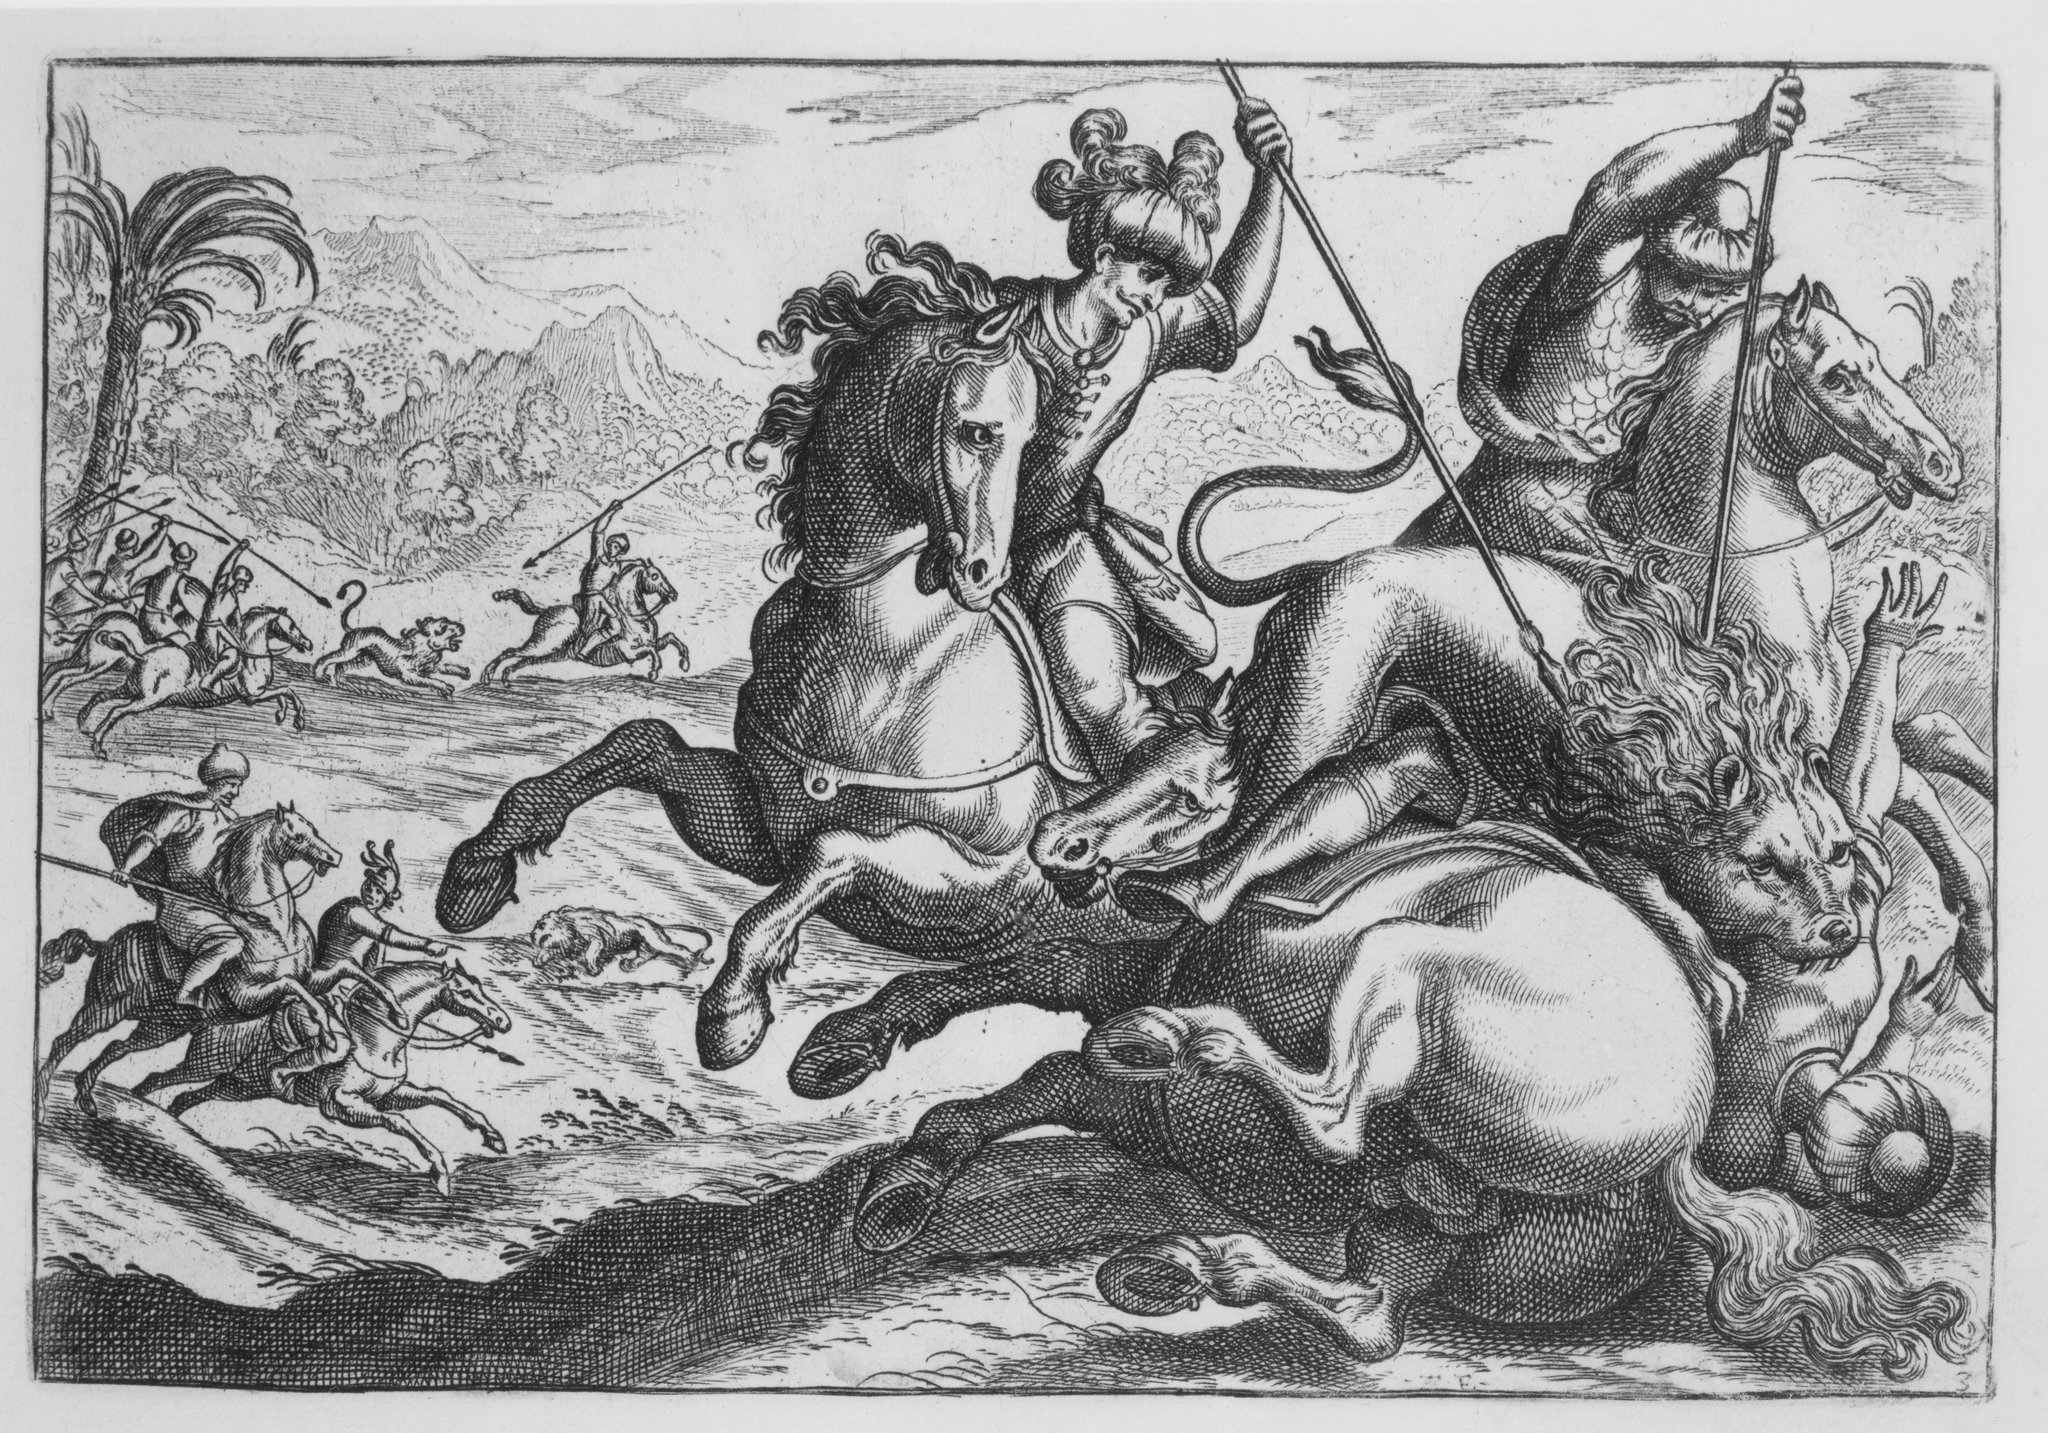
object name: print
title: Lion Hunt, from 'Hunting Scenes IV'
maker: antonio tempesta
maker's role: artist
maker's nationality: italian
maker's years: 1555-1630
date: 1567-1600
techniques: etching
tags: spears,men,hunting,horses,lions